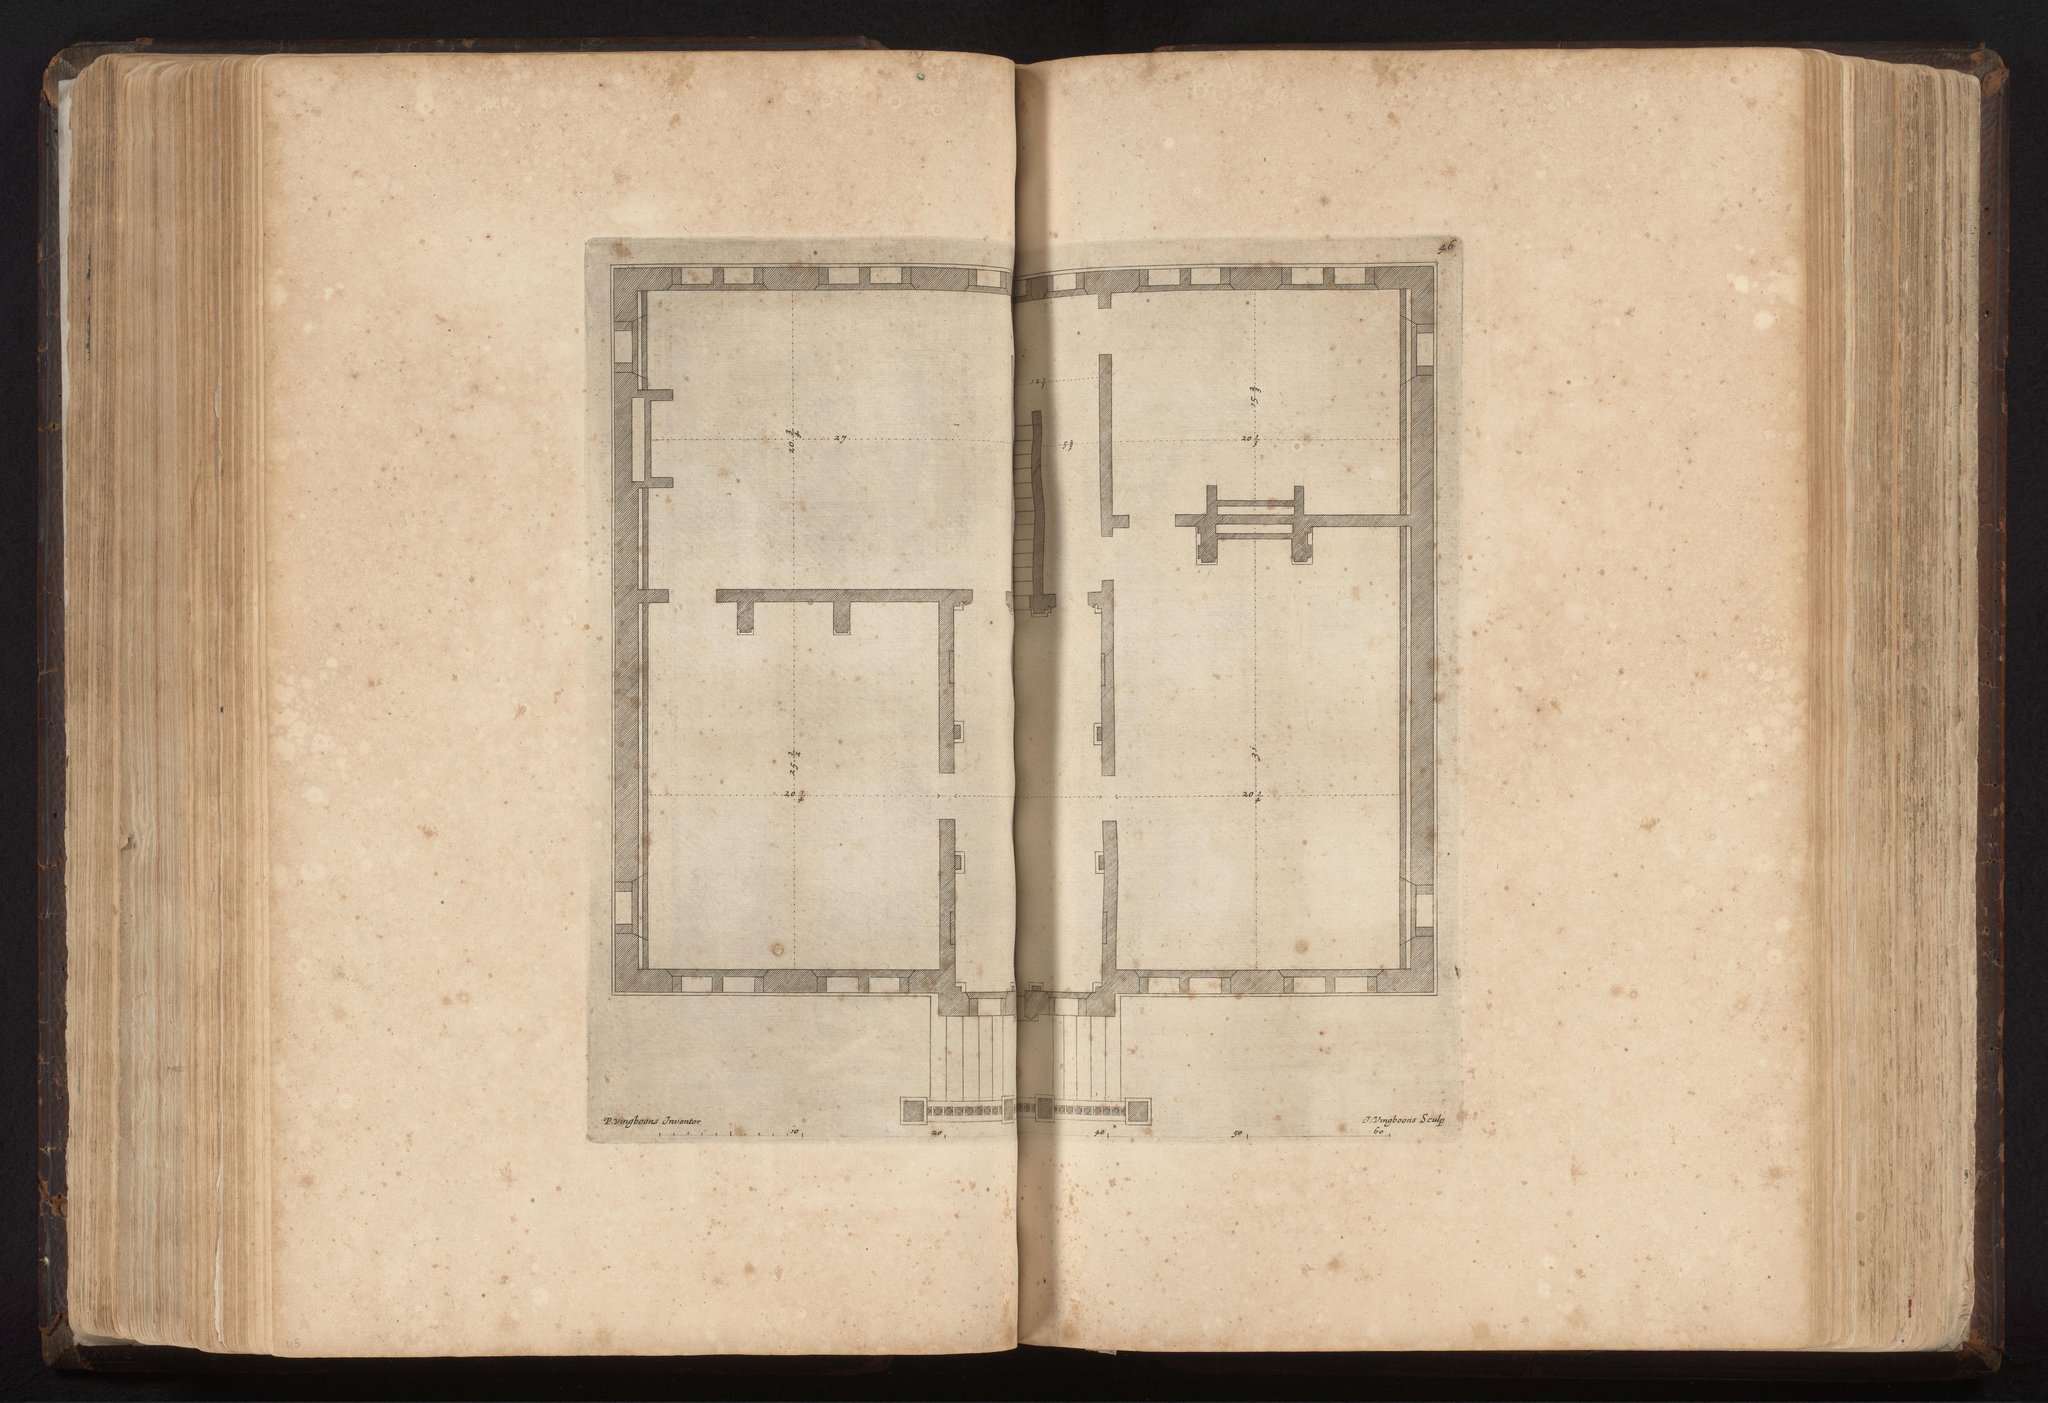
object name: print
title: Plattegrond voor het landhuis Vredenburg in de Beemster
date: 1648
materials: paper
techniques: engraving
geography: amsterdam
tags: plan ~ architecture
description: Prent uit: Afbeelsels der voornaemste gebouwen uyt alle die Philips Vingboons geordineert heeft. Amsterdam: Philips en Johannes Vinckboons en Johannes Willemszoon Blaeu, 1648.